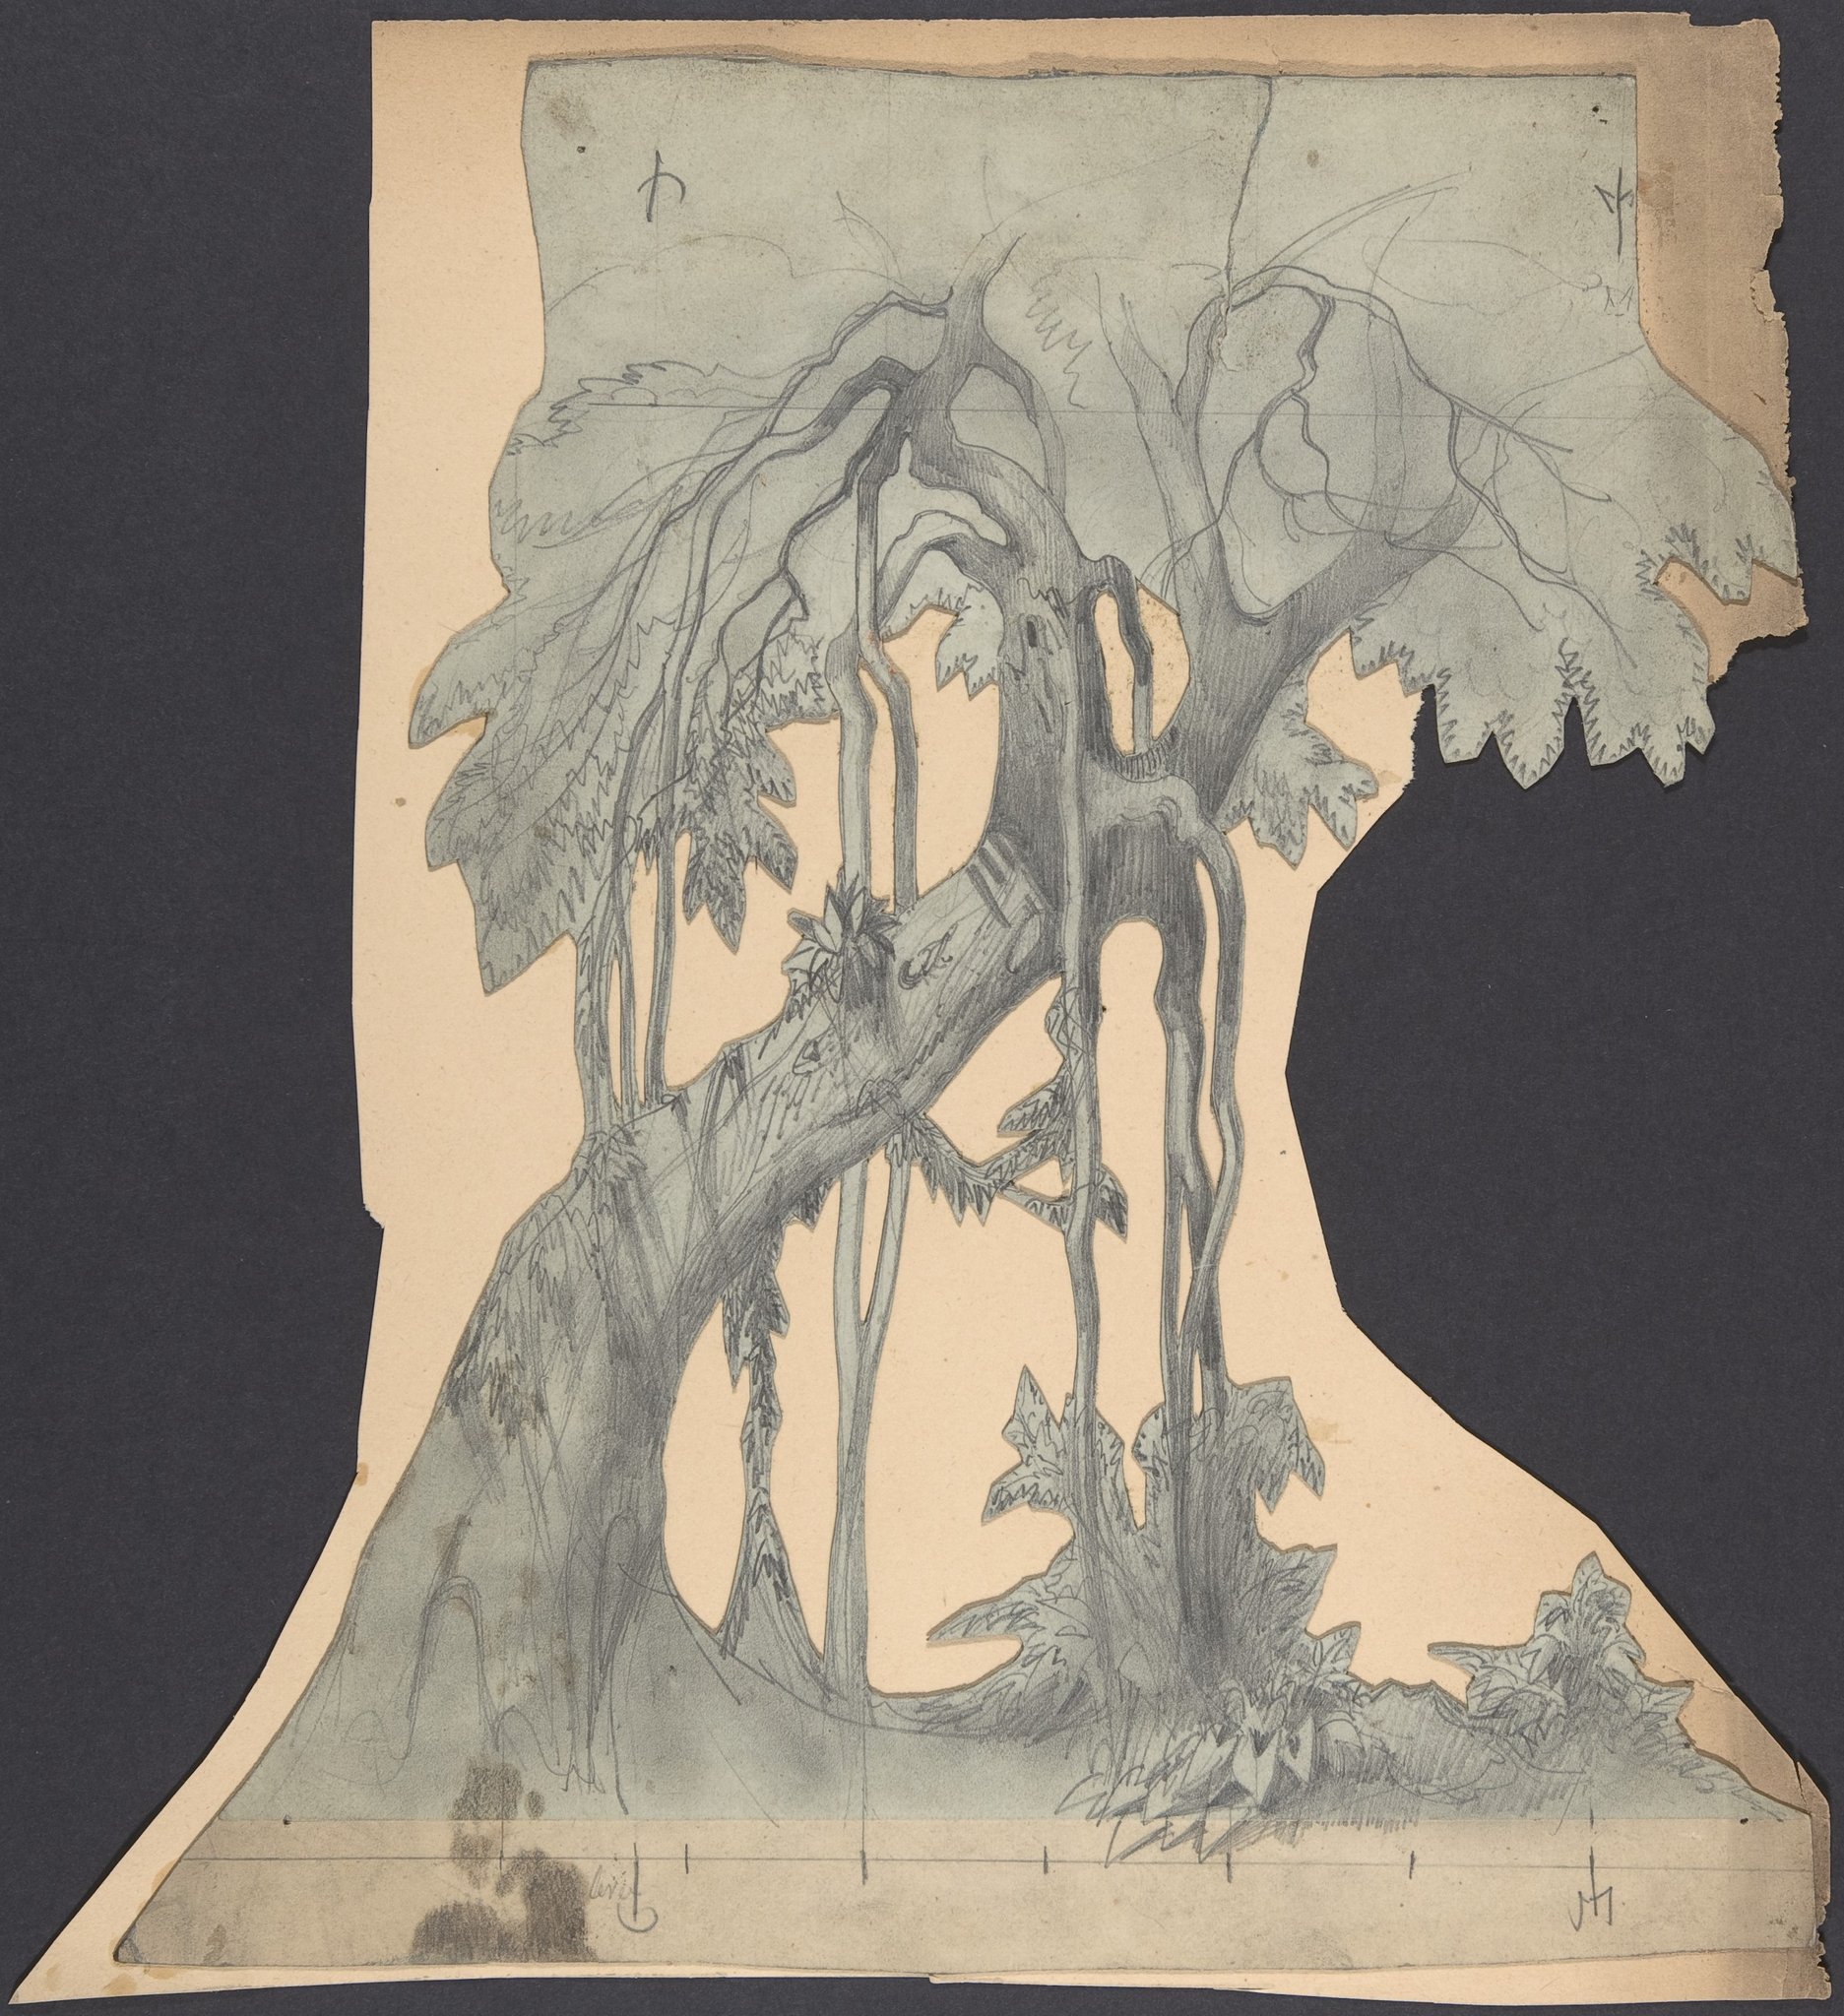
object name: drawing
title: Design for a Stage Set at the Opéra, Paris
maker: eugène cicéri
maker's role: artist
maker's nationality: french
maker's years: 1813-1890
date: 1828-1890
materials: graphite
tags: trees,stage design